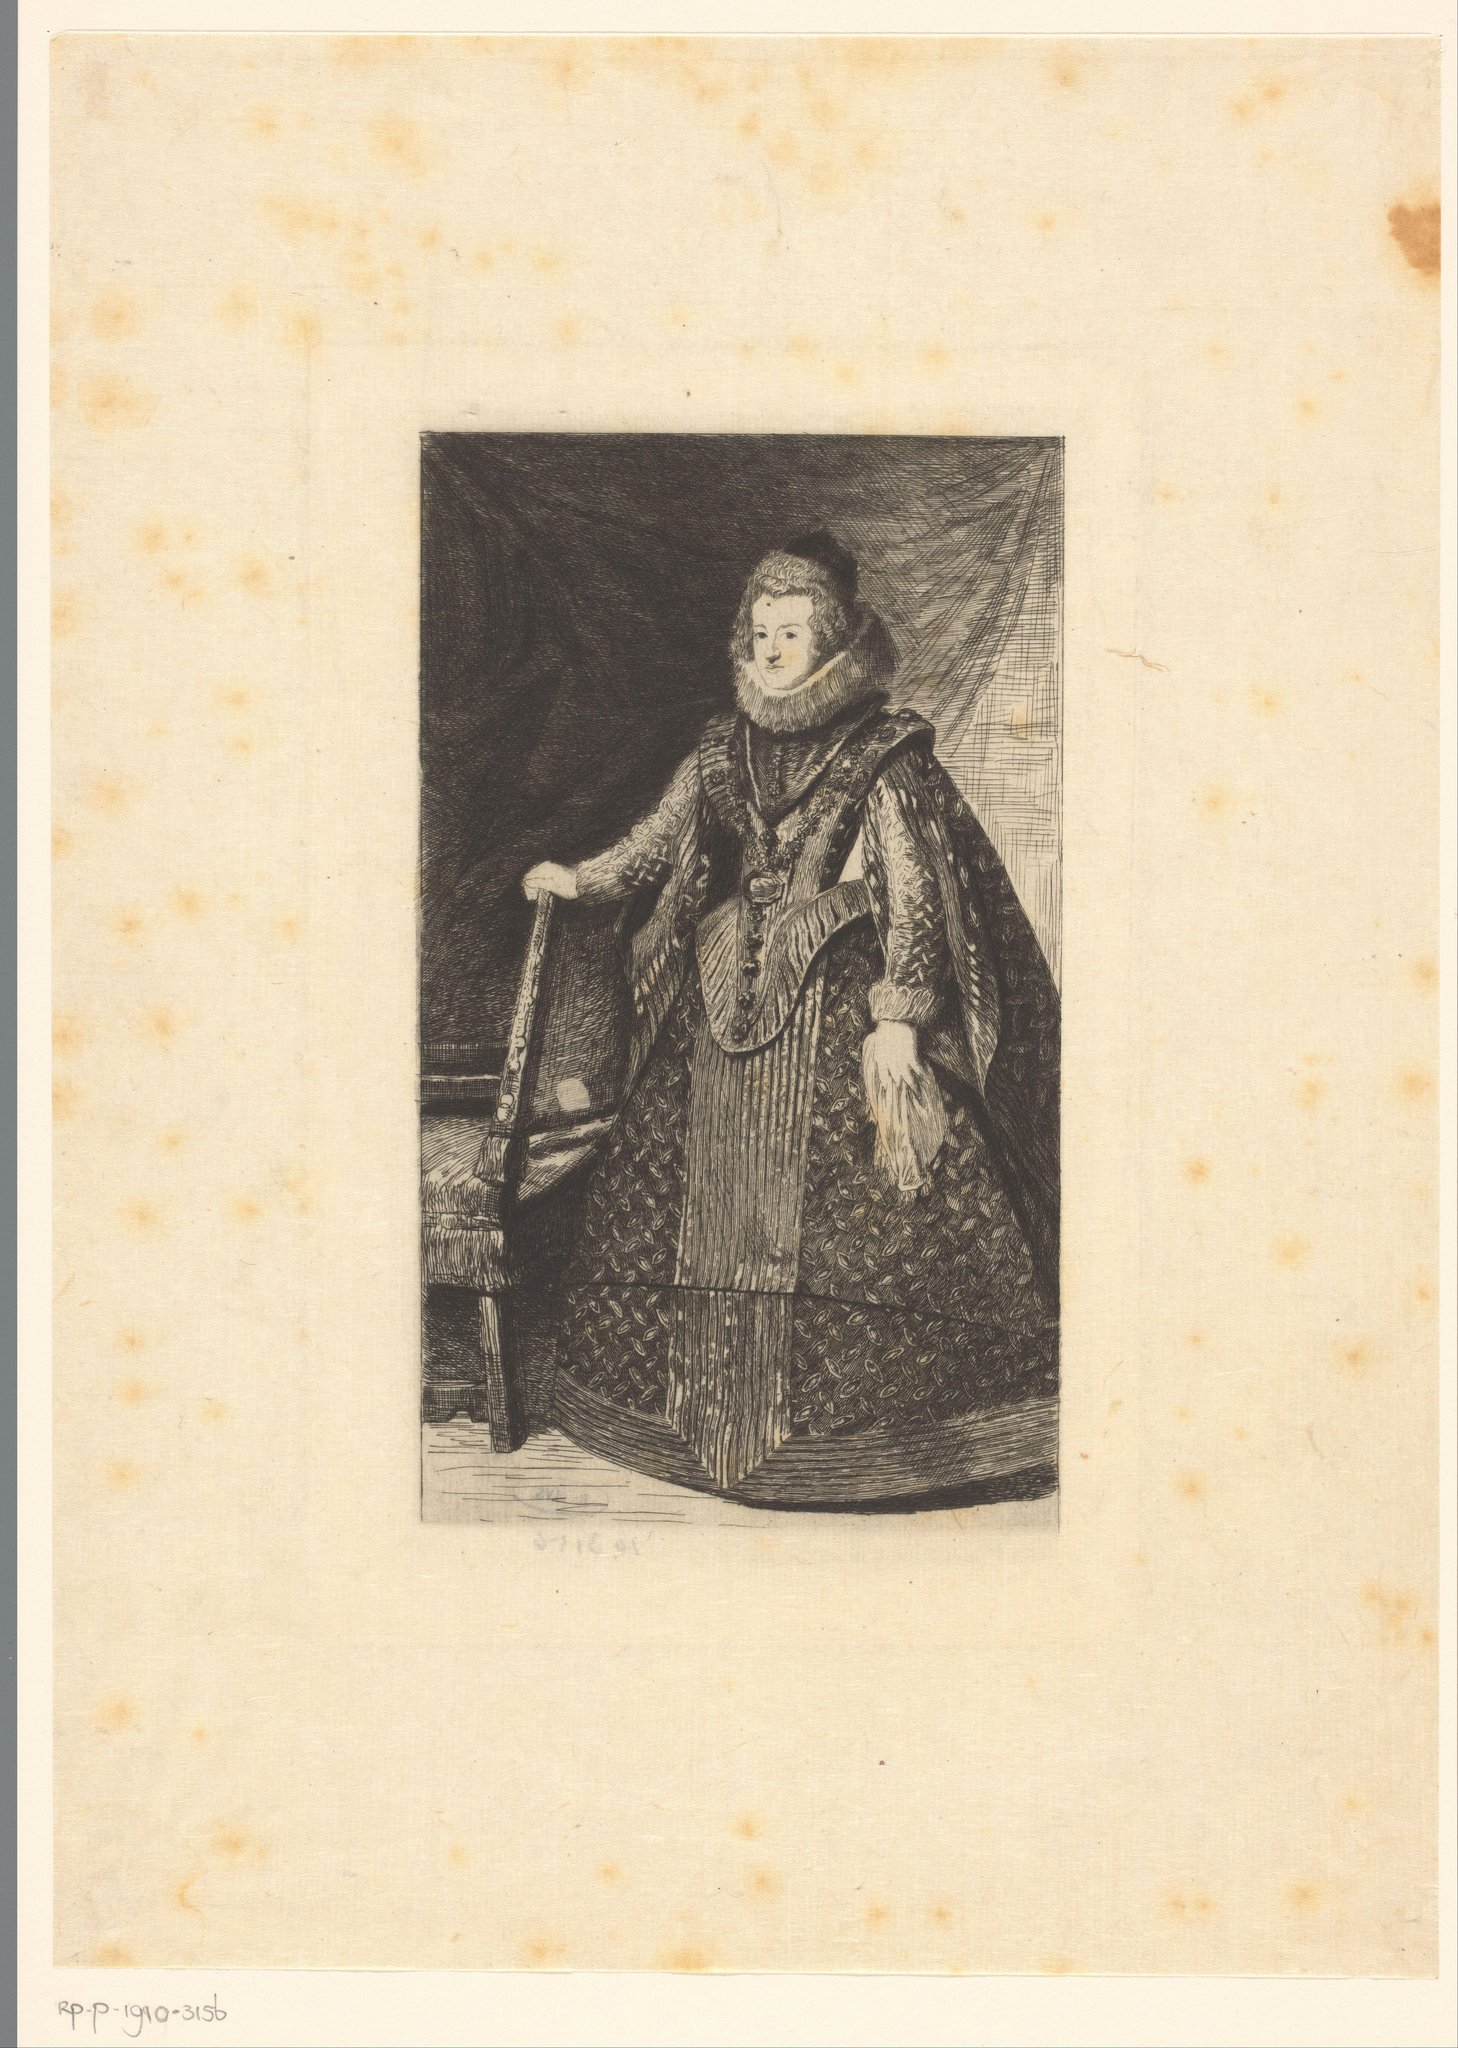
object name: print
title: Portret van Elisabeth van Bourbon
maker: léopold flameng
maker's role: print maker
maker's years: 1831-1911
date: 1874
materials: paper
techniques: drypoint, etching, intaglio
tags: elisabeth of france (queen of spain and portugal), historical persons - bb - woman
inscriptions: collector's mark: Lugt 2228